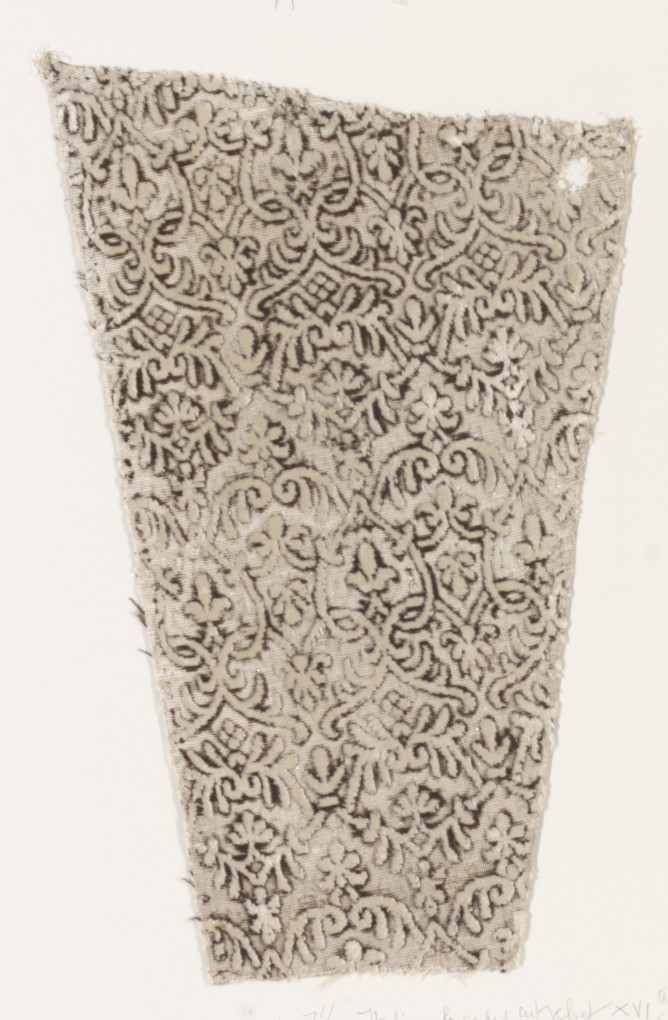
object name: fragment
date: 1501-1600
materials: metal thread, silk